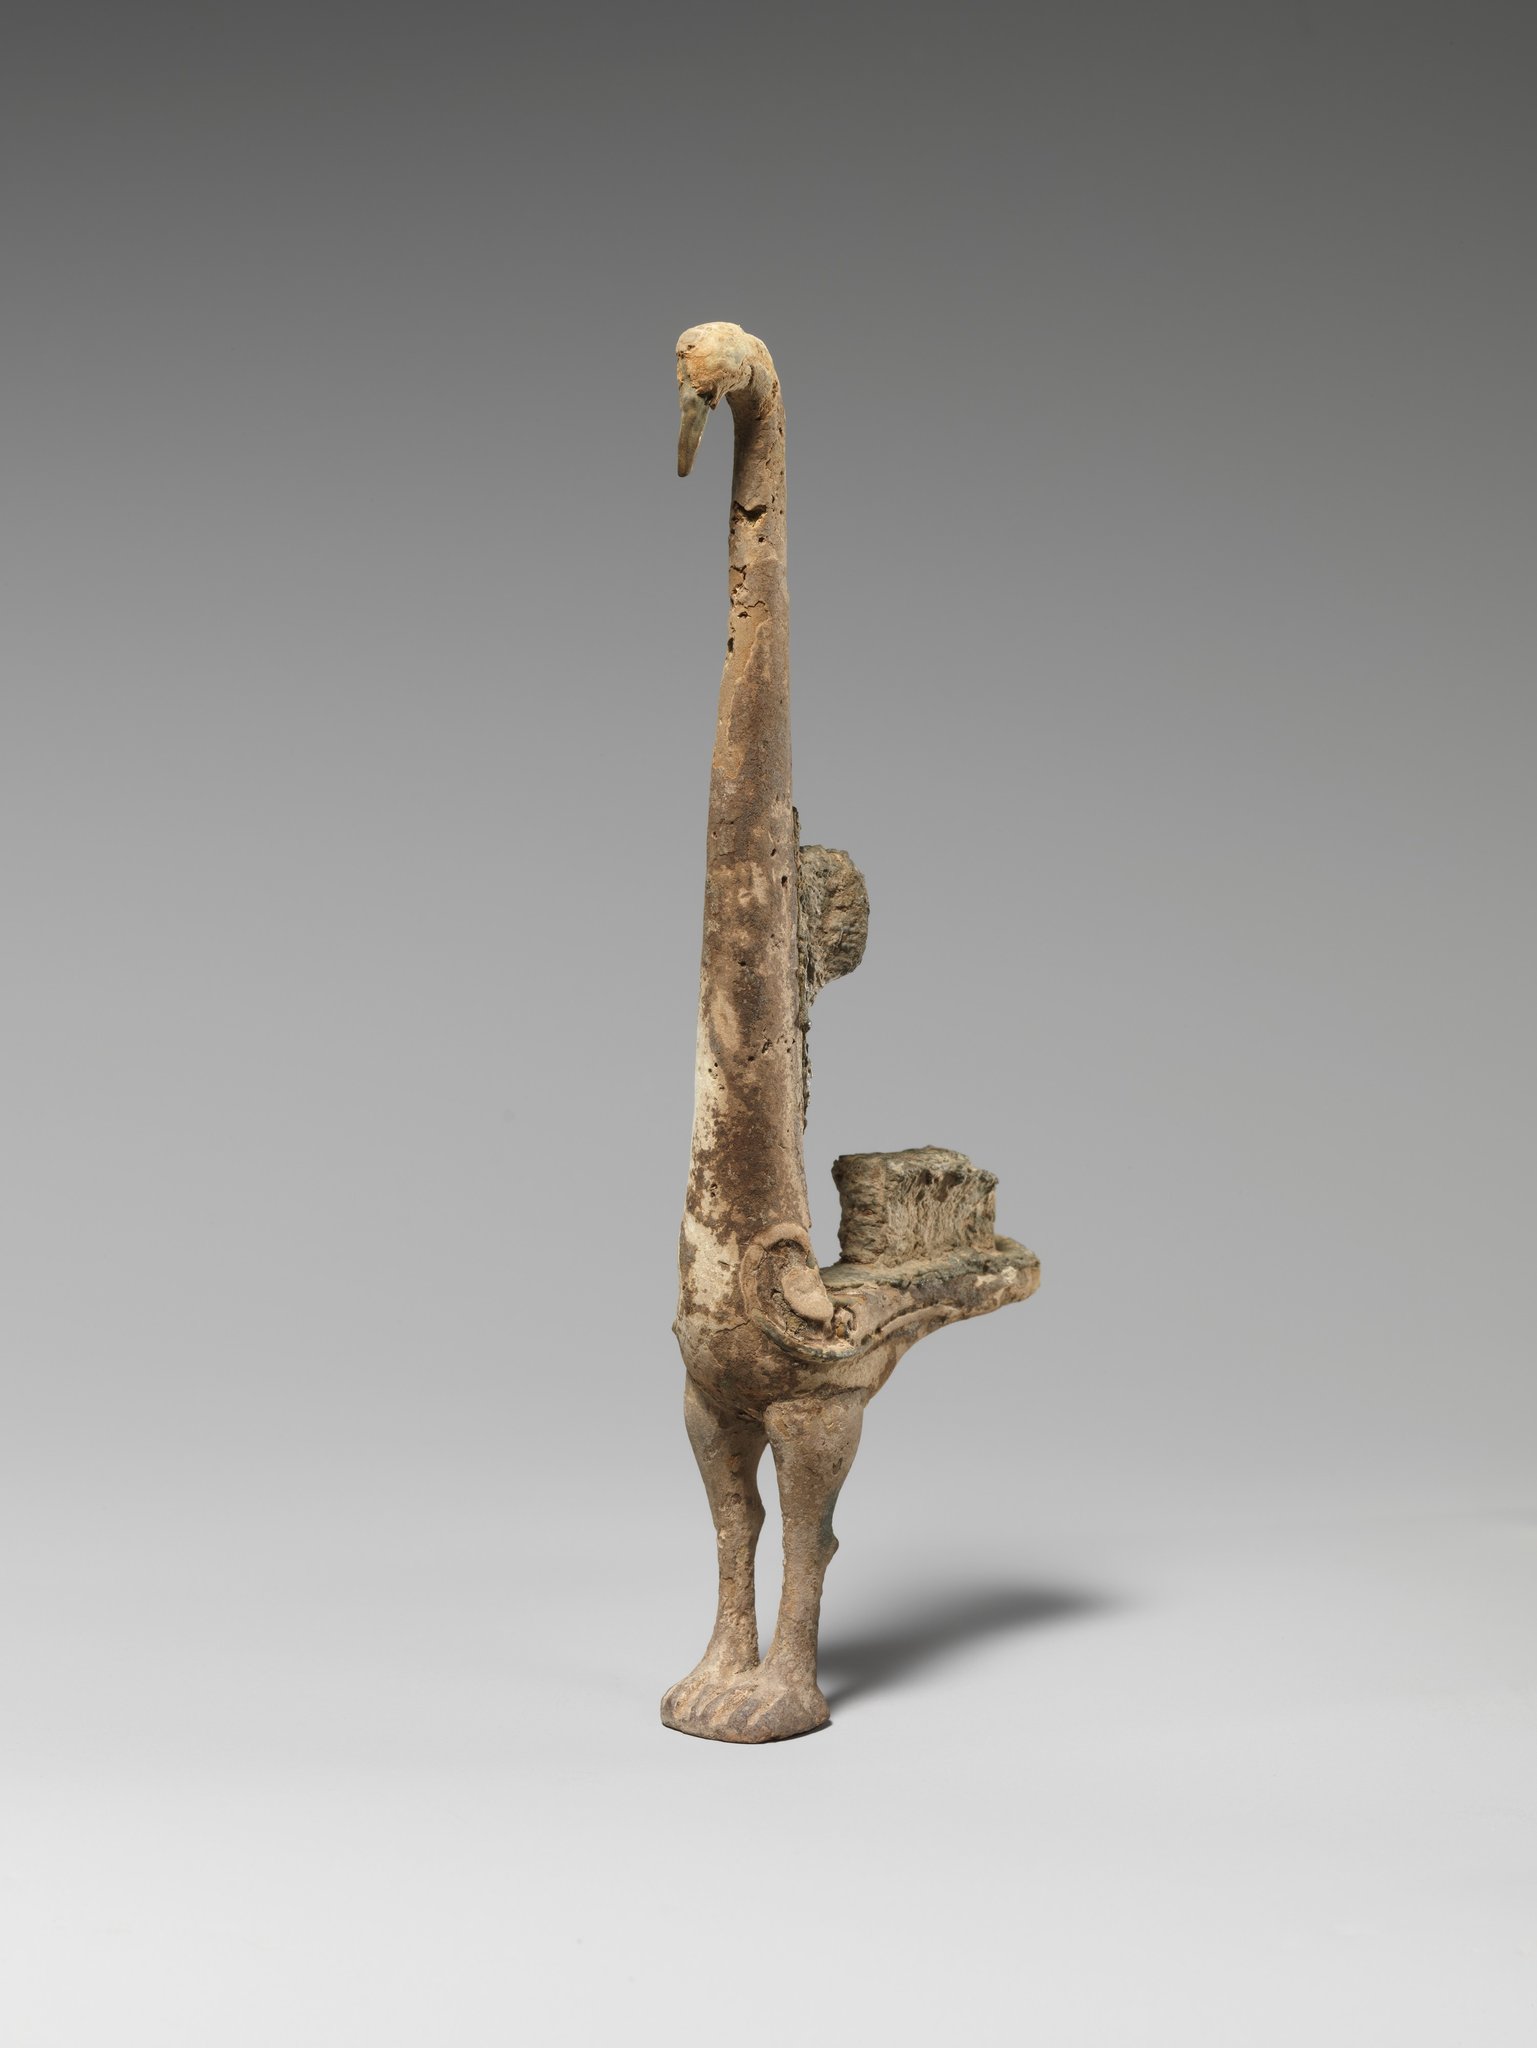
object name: vessel leg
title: Vessel leg in the form of a bird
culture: chinese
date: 500-201 BCE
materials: bronze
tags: birds